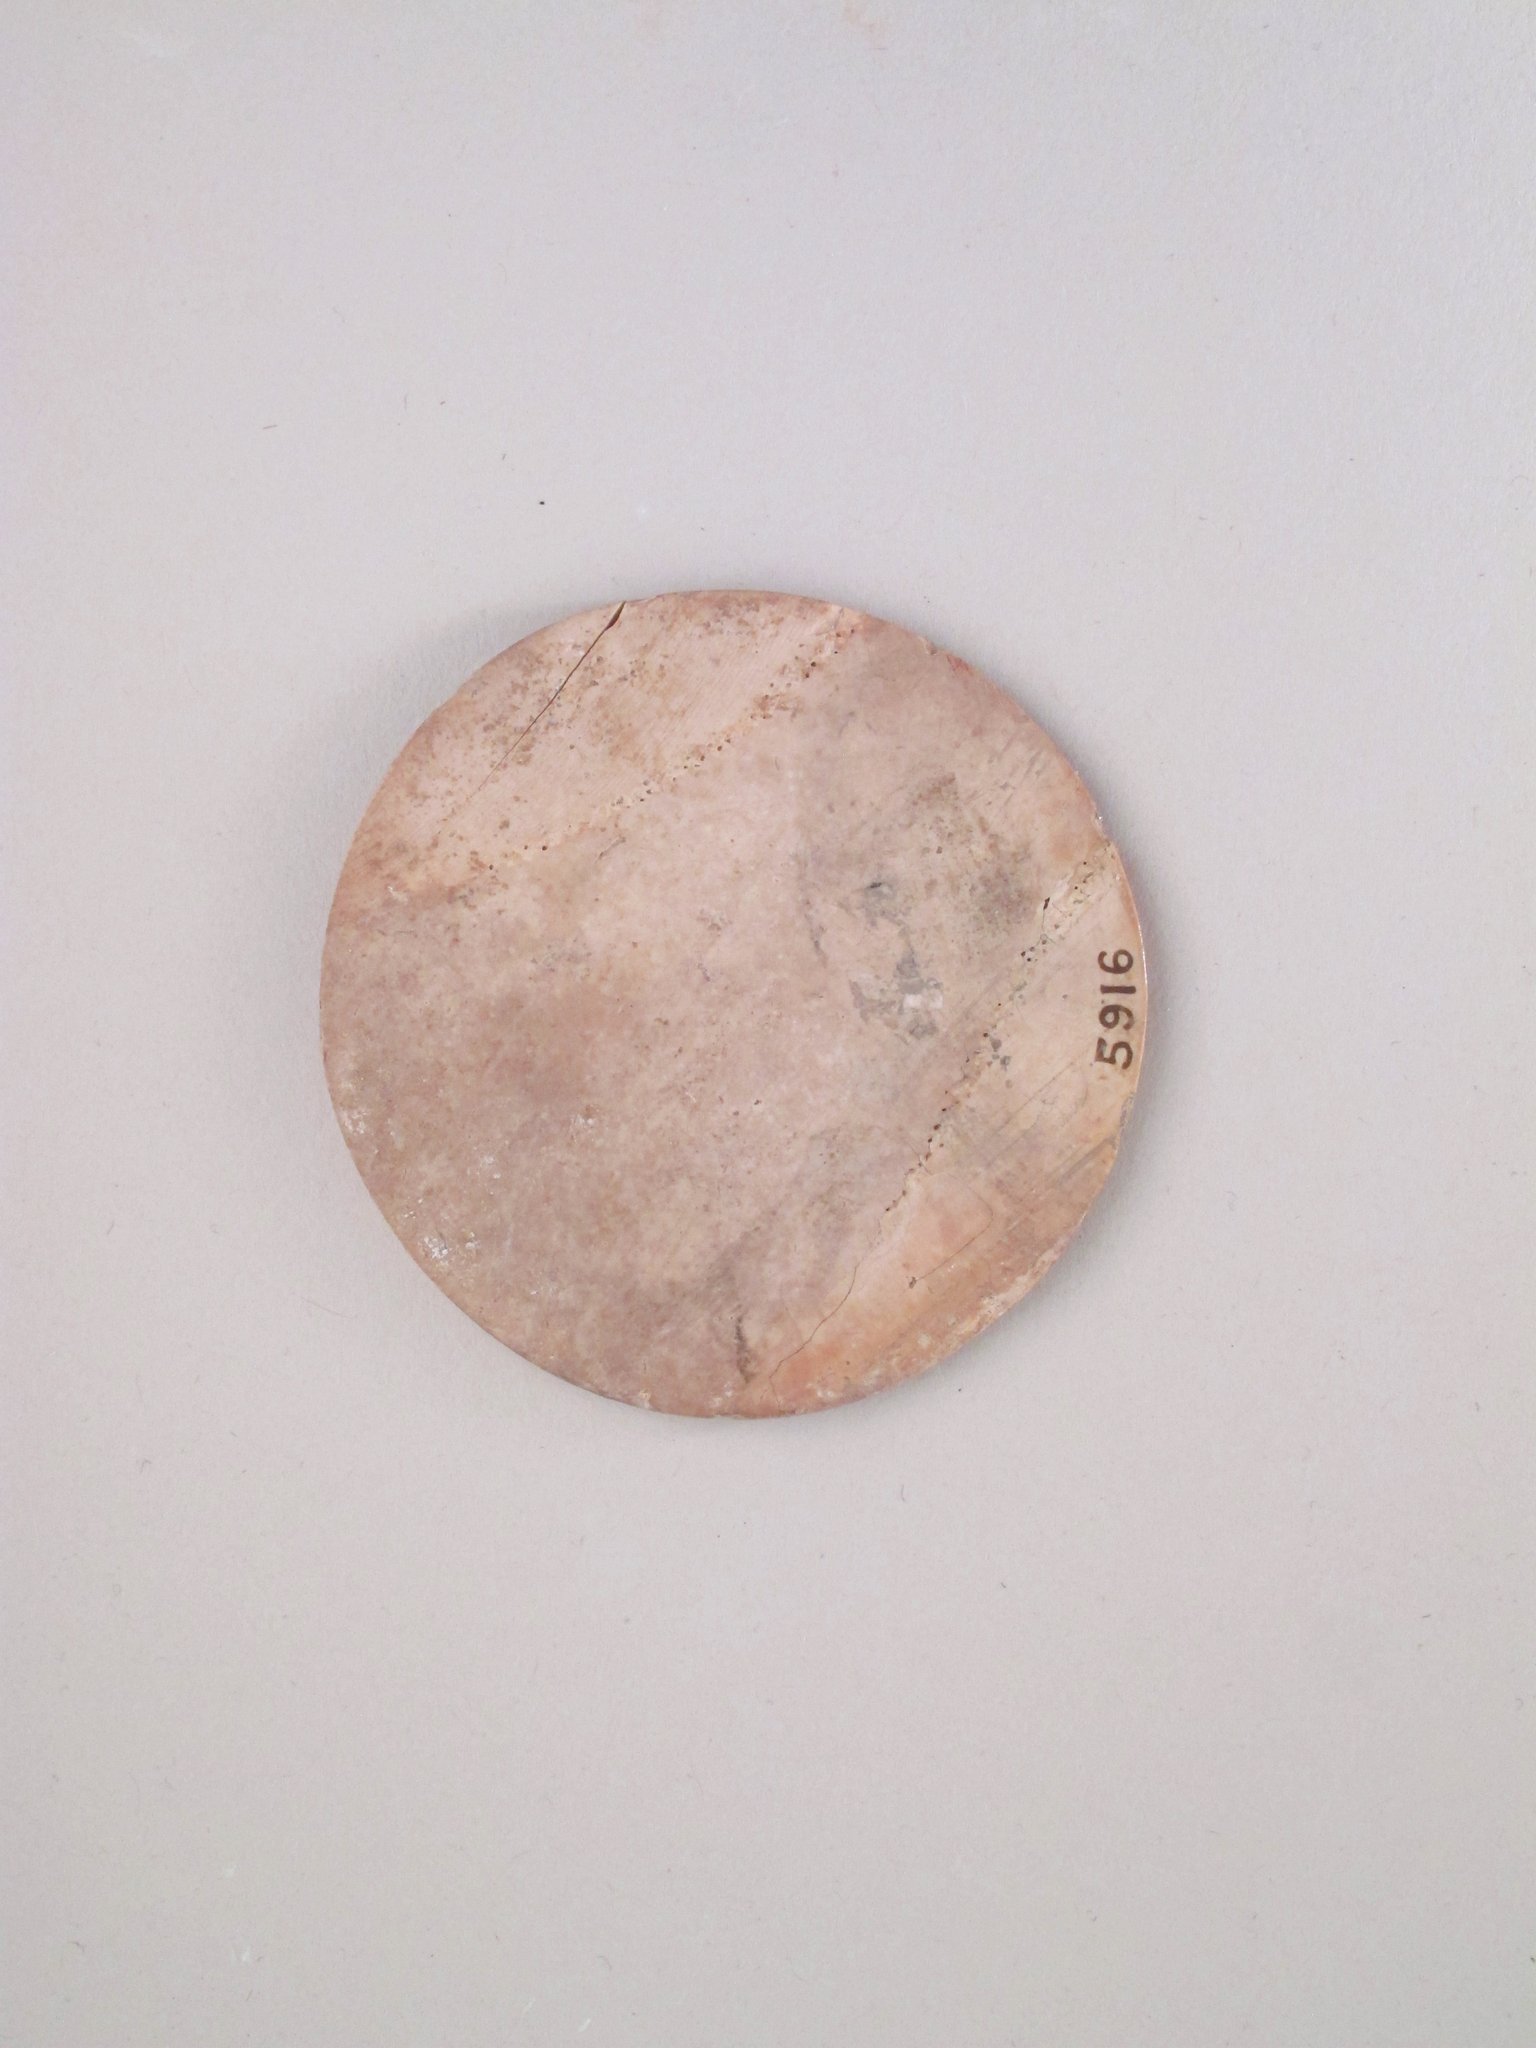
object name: roundel, disk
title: Ivory disk of a pyxis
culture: cypriot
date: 1300-1101 BCE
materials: ivory